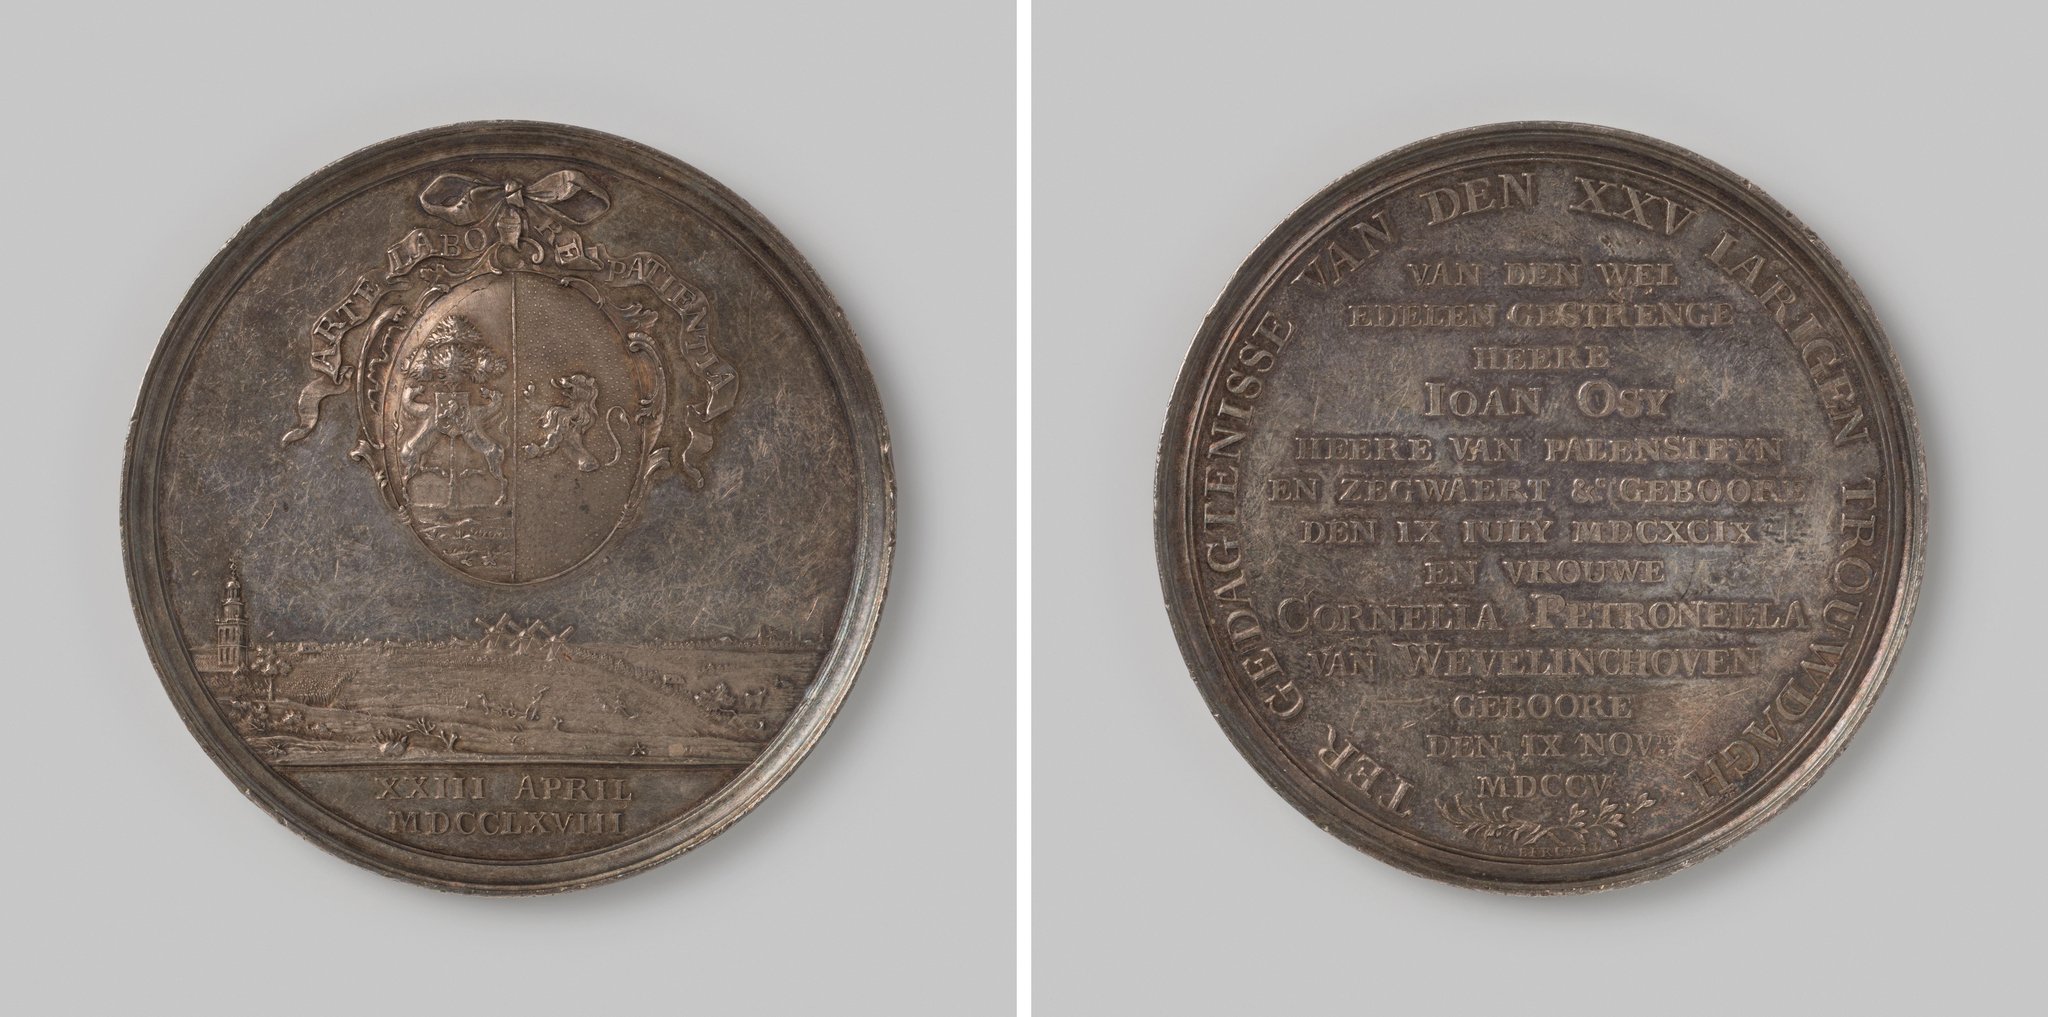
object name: history medal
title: Vijfentwintigjarig huwelijk van Johan Osy van Palensteyn en Zegwaert en Cornelia Petronella van Wevelinchoven1768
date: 1768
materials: silver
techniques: striking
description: Forse zilveren penning, op de voorzijde en ovaal wapenschild, aan een strik van beschreven lint, boven het landschap bij Zegwaart, met afsnedetekst, op de keerzijde dertien regels tekst met omschrift.